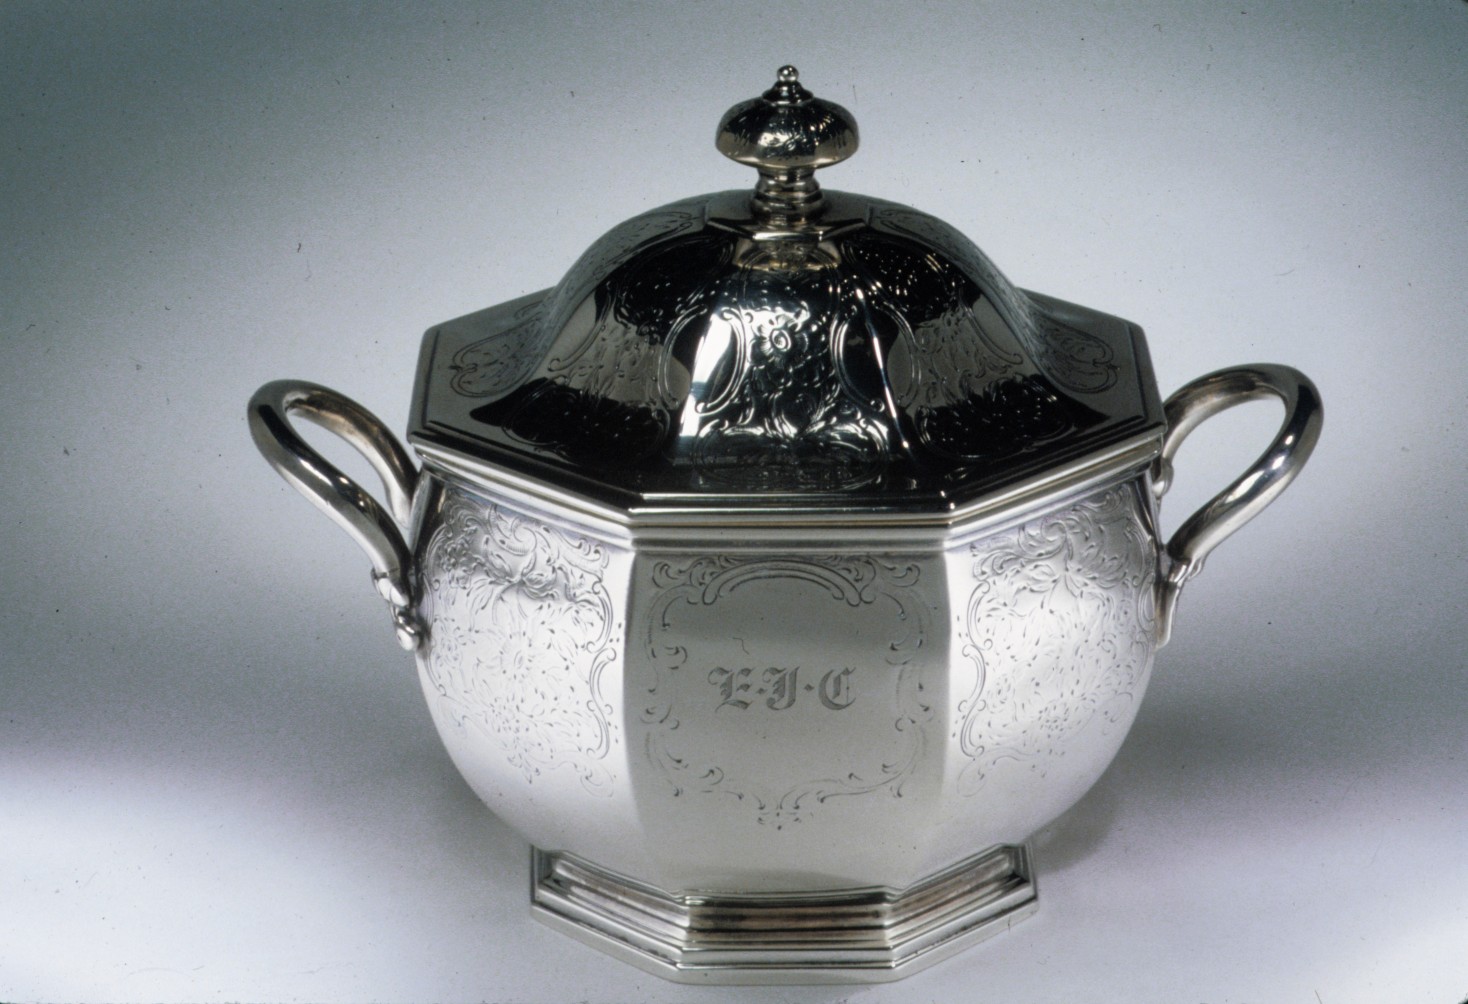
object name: sugar bowl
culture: american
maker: william forbes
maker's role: maker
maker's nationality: american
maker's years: 1826-1863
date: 1835-1840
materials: silver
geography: united states